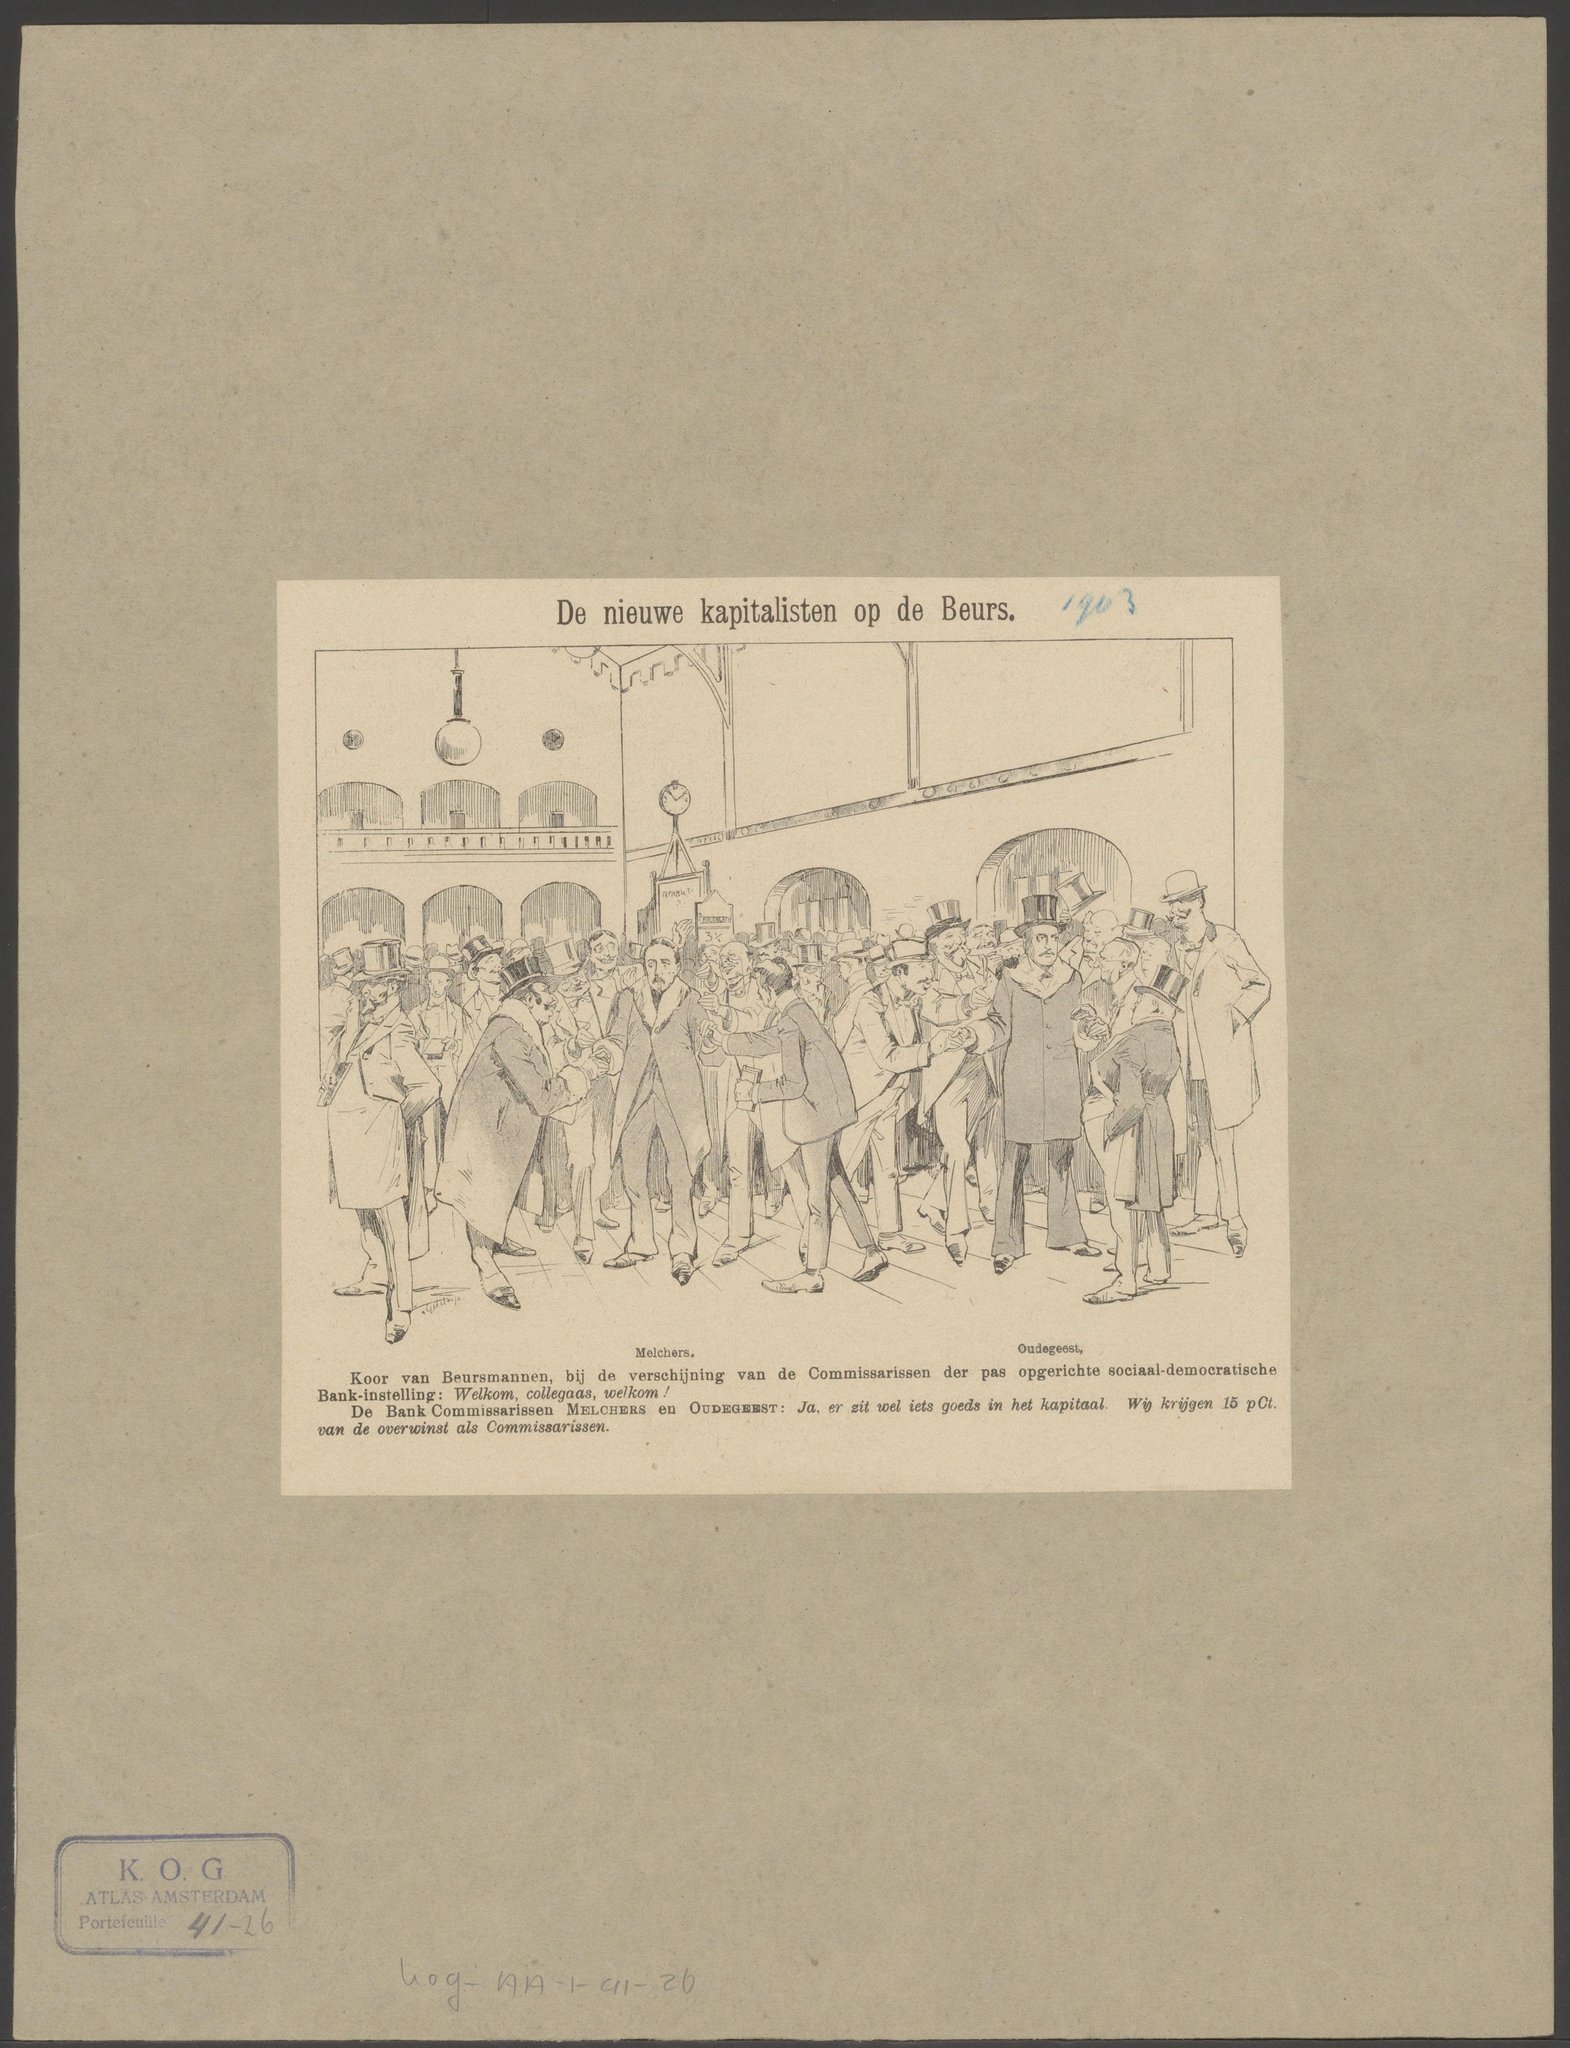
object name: photomechanical print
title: De nieuwe kapitalisten op de Beurs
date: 1903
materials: paper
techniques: letterpress printing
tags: utrecht, stock exchange, stock-market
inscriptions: collector's mark: Lugt 1461b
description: Gerrit Willem Melchers en Jan Oudegeest van de SDAP worden gretig ontvangen door het koor van beursmannen op de Amsterdamse beurs. Onderwerpsrubriek binnen de Atlas Amsterdam: B. Beurs op het Damrak.